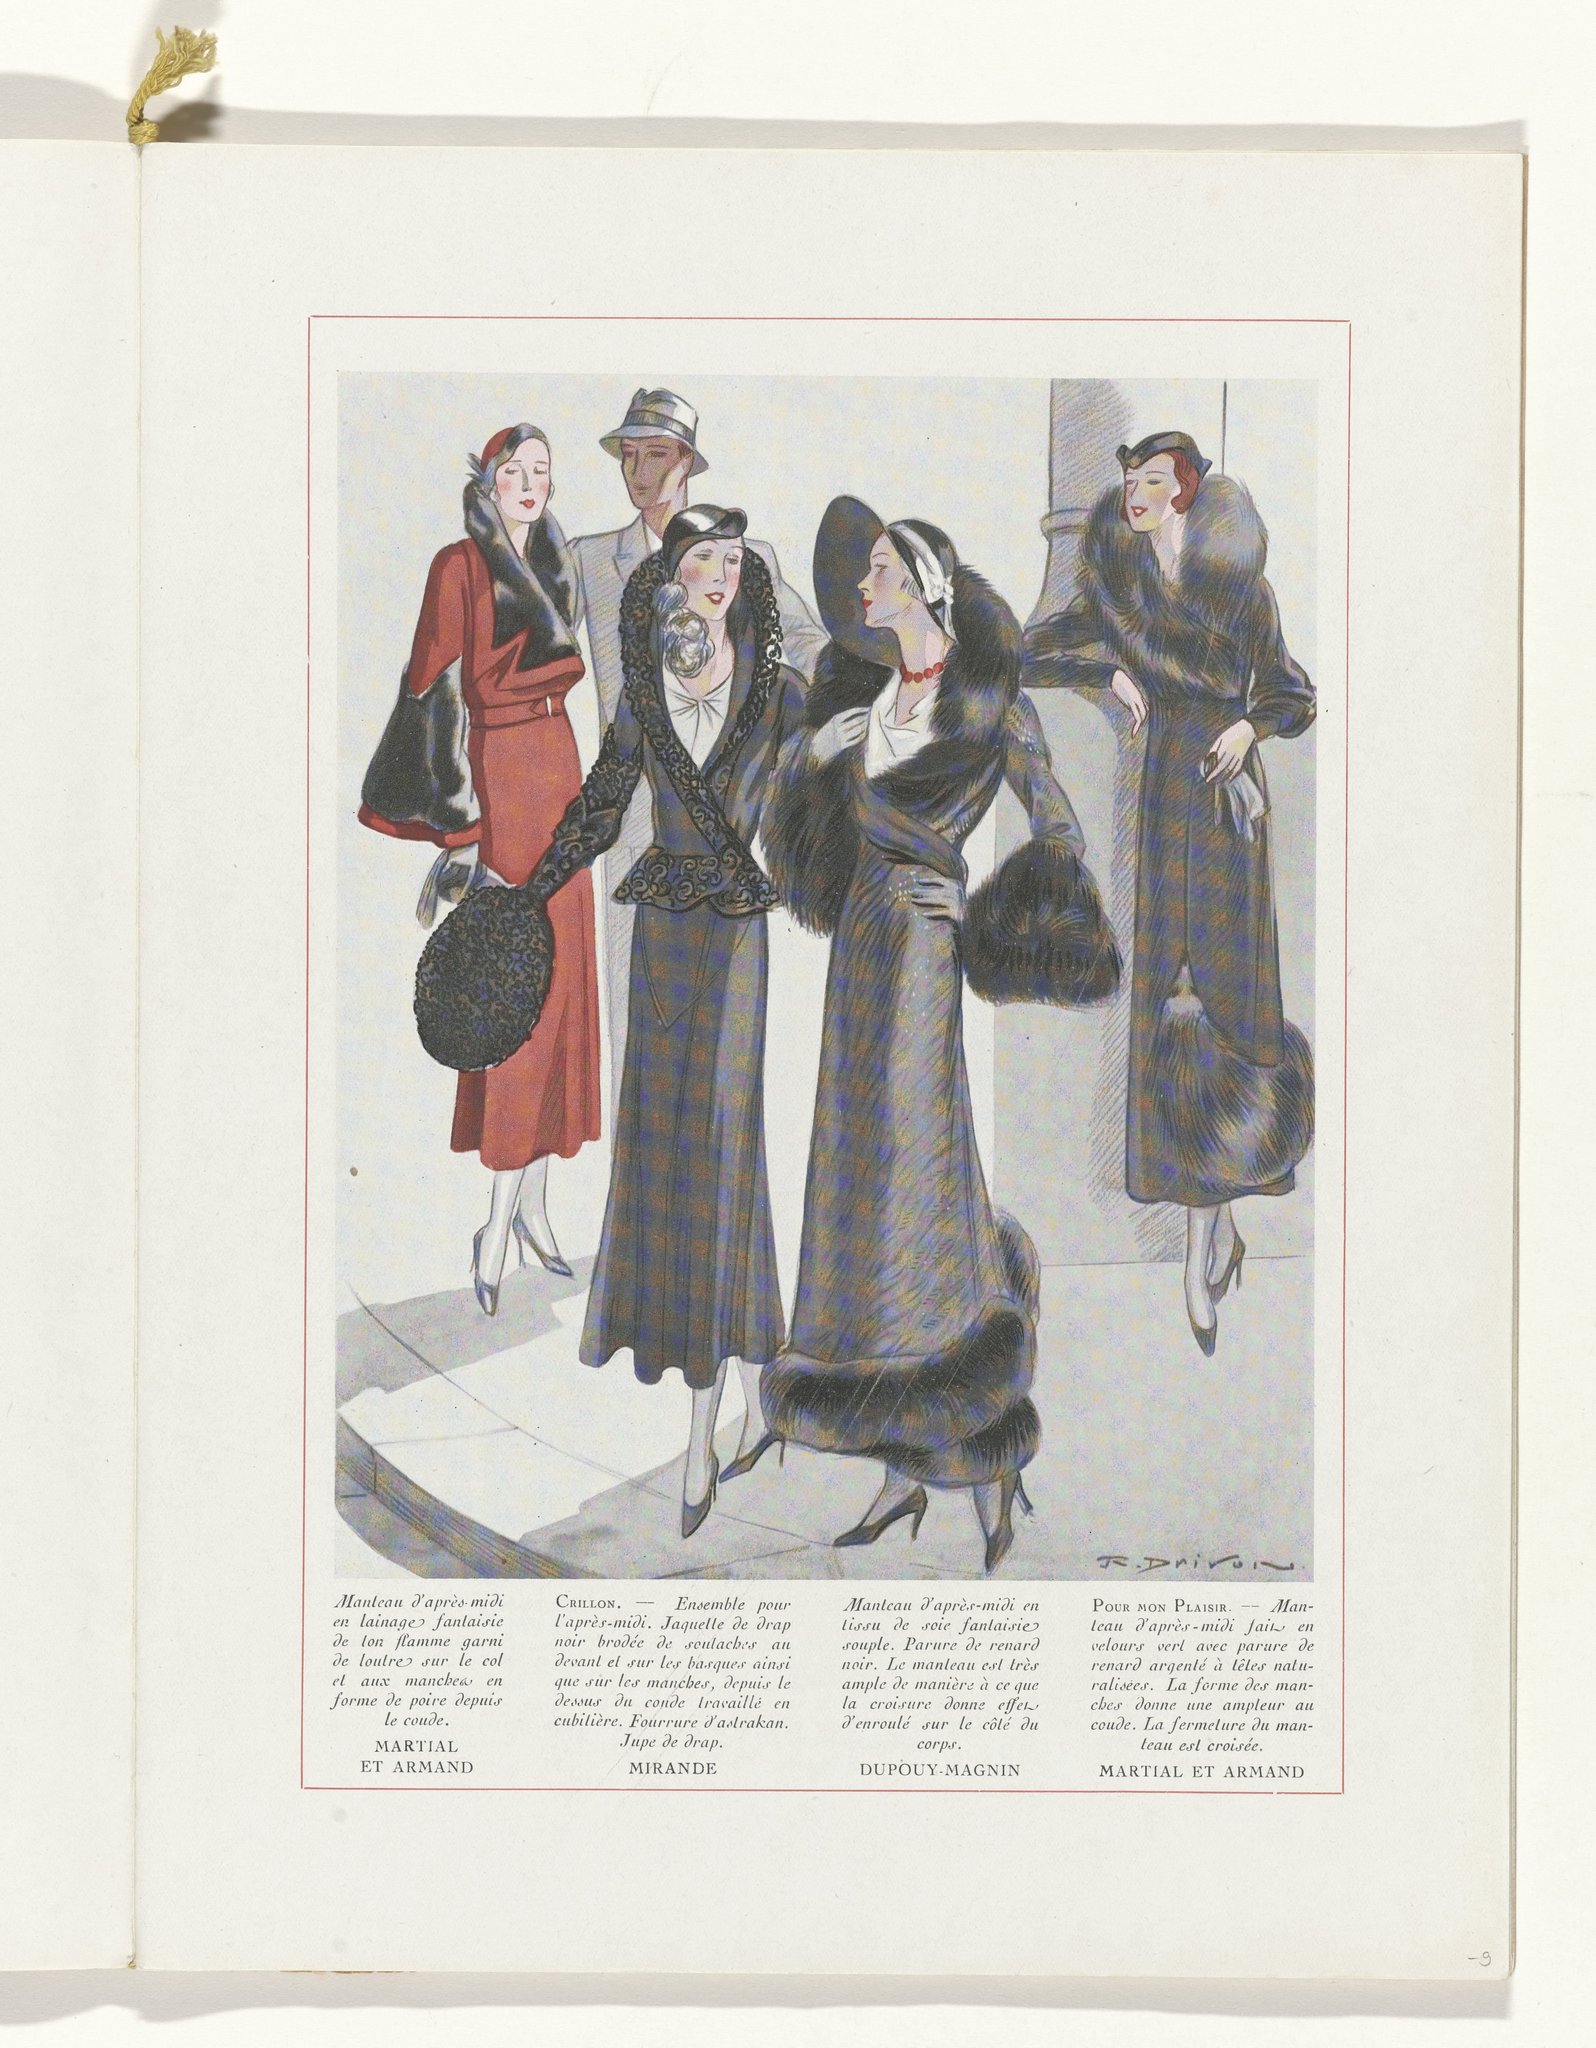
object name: fashion print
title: Art - Goût - Beauté, Feuillets de l' élégance féminine, Novembre 1931, No. 135, 12e Année, p. 9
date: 1931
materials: paper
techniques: printing, photography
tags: border, ribbon, braid (+ fur used for clothes), coat (+ women's clothes), fashion plates, head-gear: hat (+ women's clothes), skirt (+ women's clothes), muff (+ fur used for clothes), neck-gear: collar (+ fur used for clothes)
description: Van links naar rechts: mantel voor de middag van rode wol, gegarneerd met otterbont, van Martial et Armand. Ensemble voor de middag van Mirande. Mantel voor de middag van zijde, gegarneerd met zwart vossenbont, van Dupouy-Magnin. Mantel voor middag van velours met een vossebont, van Martial et Armand. Pagina uit het modetijdschrift Art-Goût-Beauté (1920-1933).